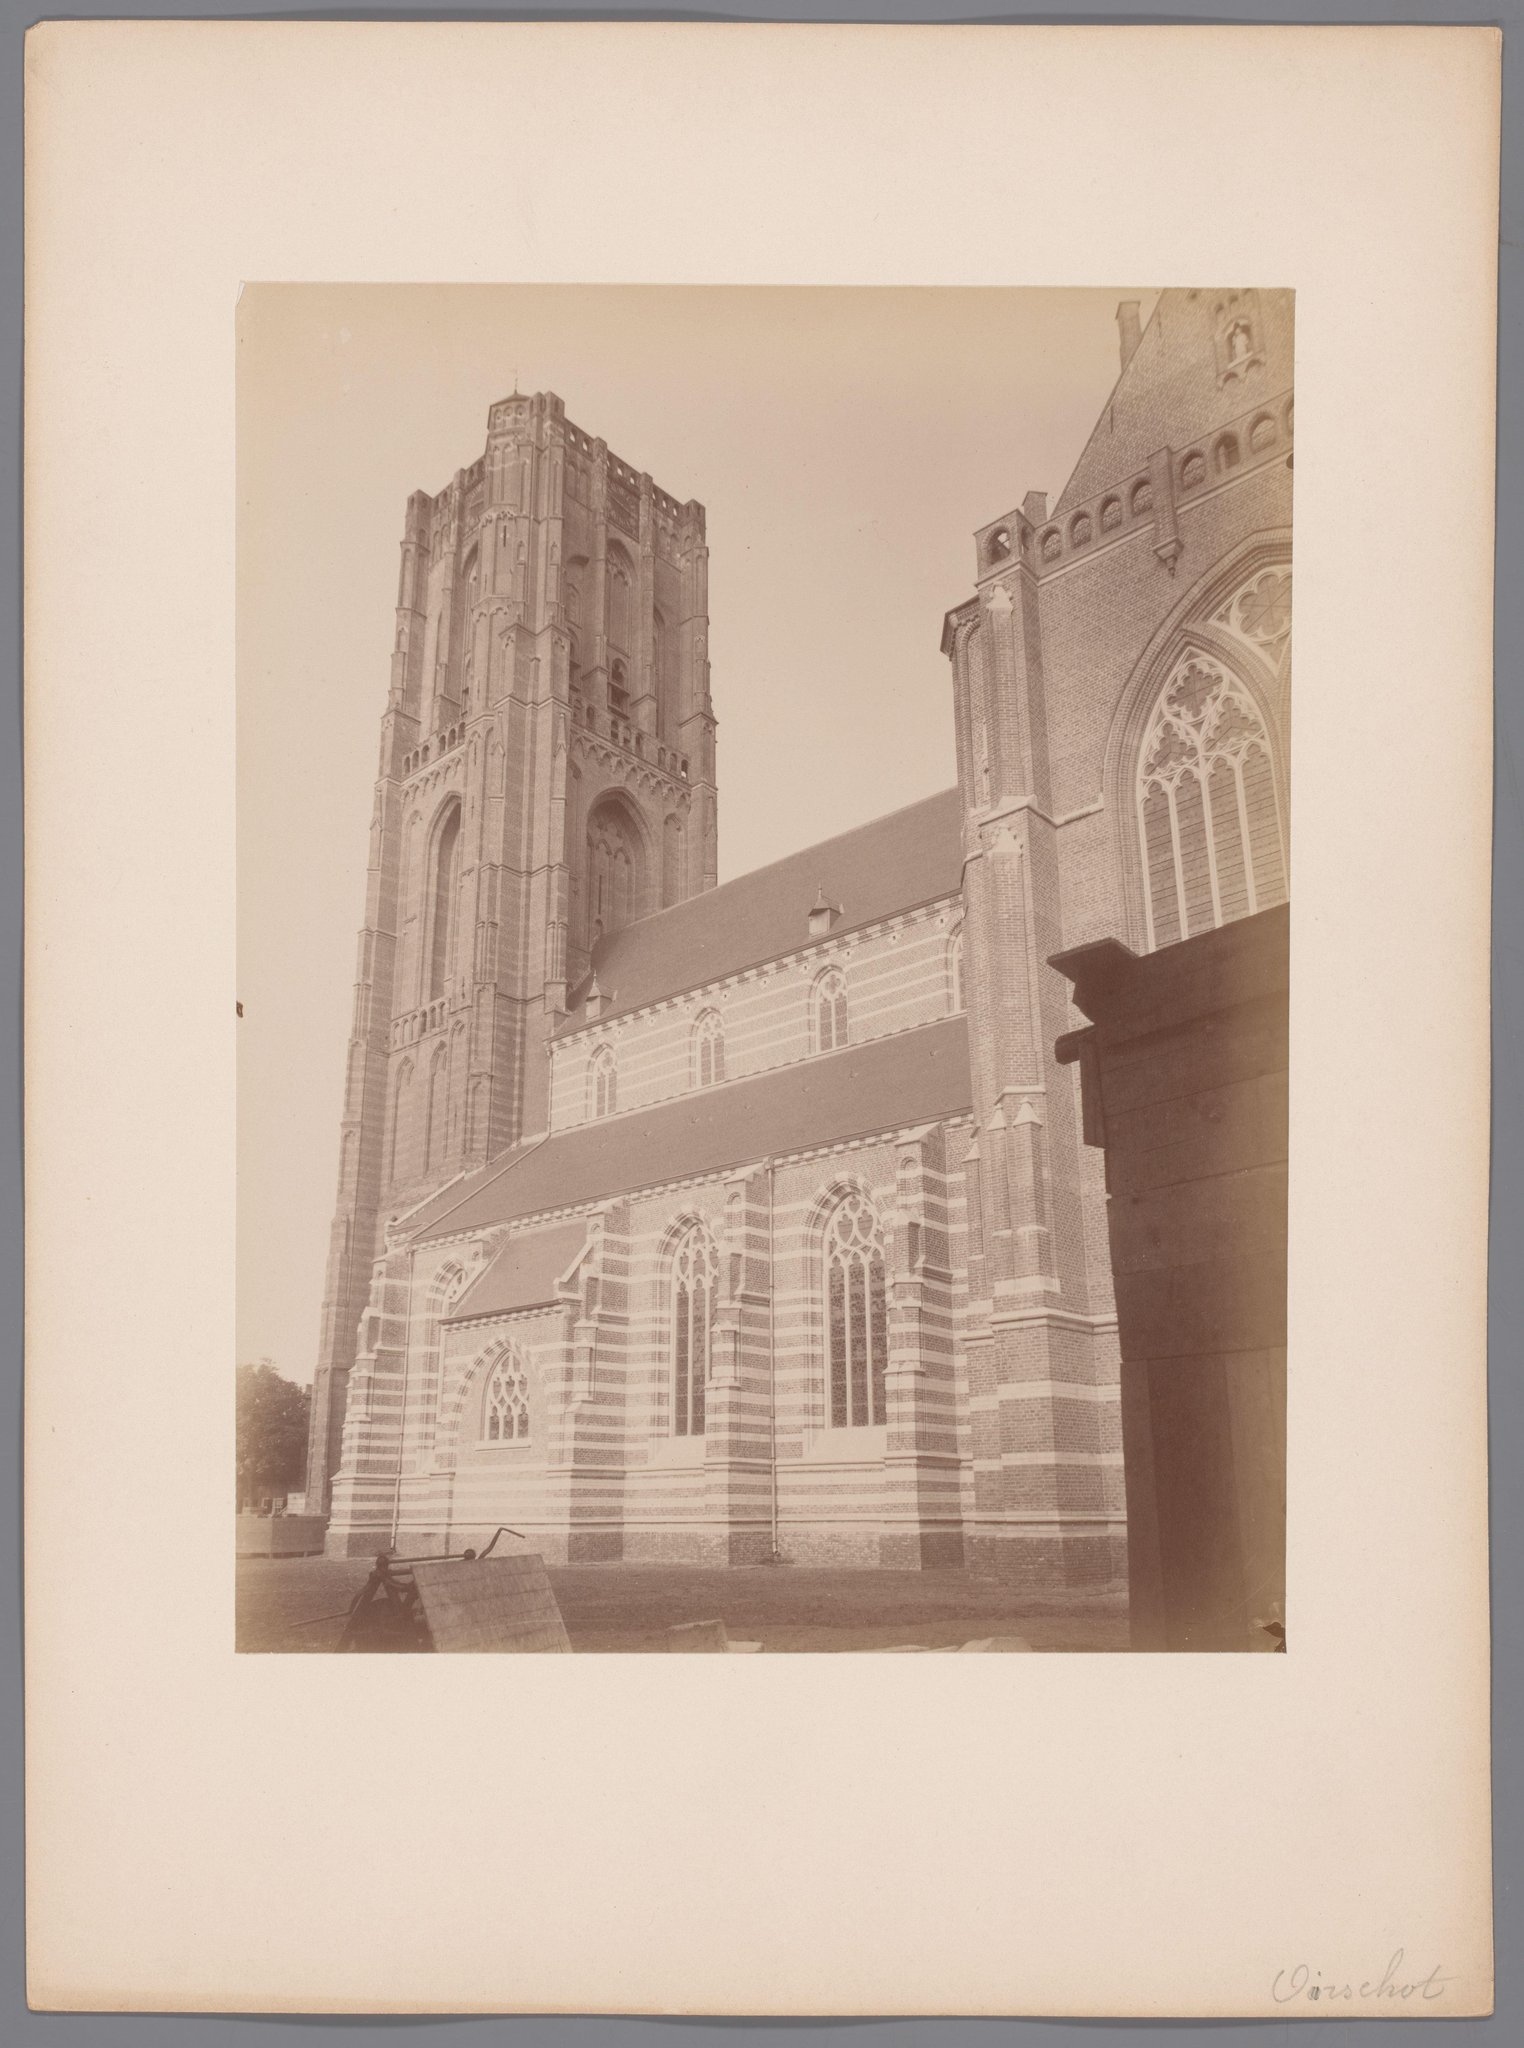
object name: photograph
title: Toren van de Sint-Pertrusbasiliek te Oirschot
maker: anoniem (monumentenzorg)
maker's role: fotograaf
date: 1890-1920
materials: cardboard, photographic support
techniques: albumen print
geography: oirschot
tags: parts of church exterior and annexes: tower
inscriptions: annotation: ‘Oorschot R.K. Kerk’, annotation: ‘Oirschot’